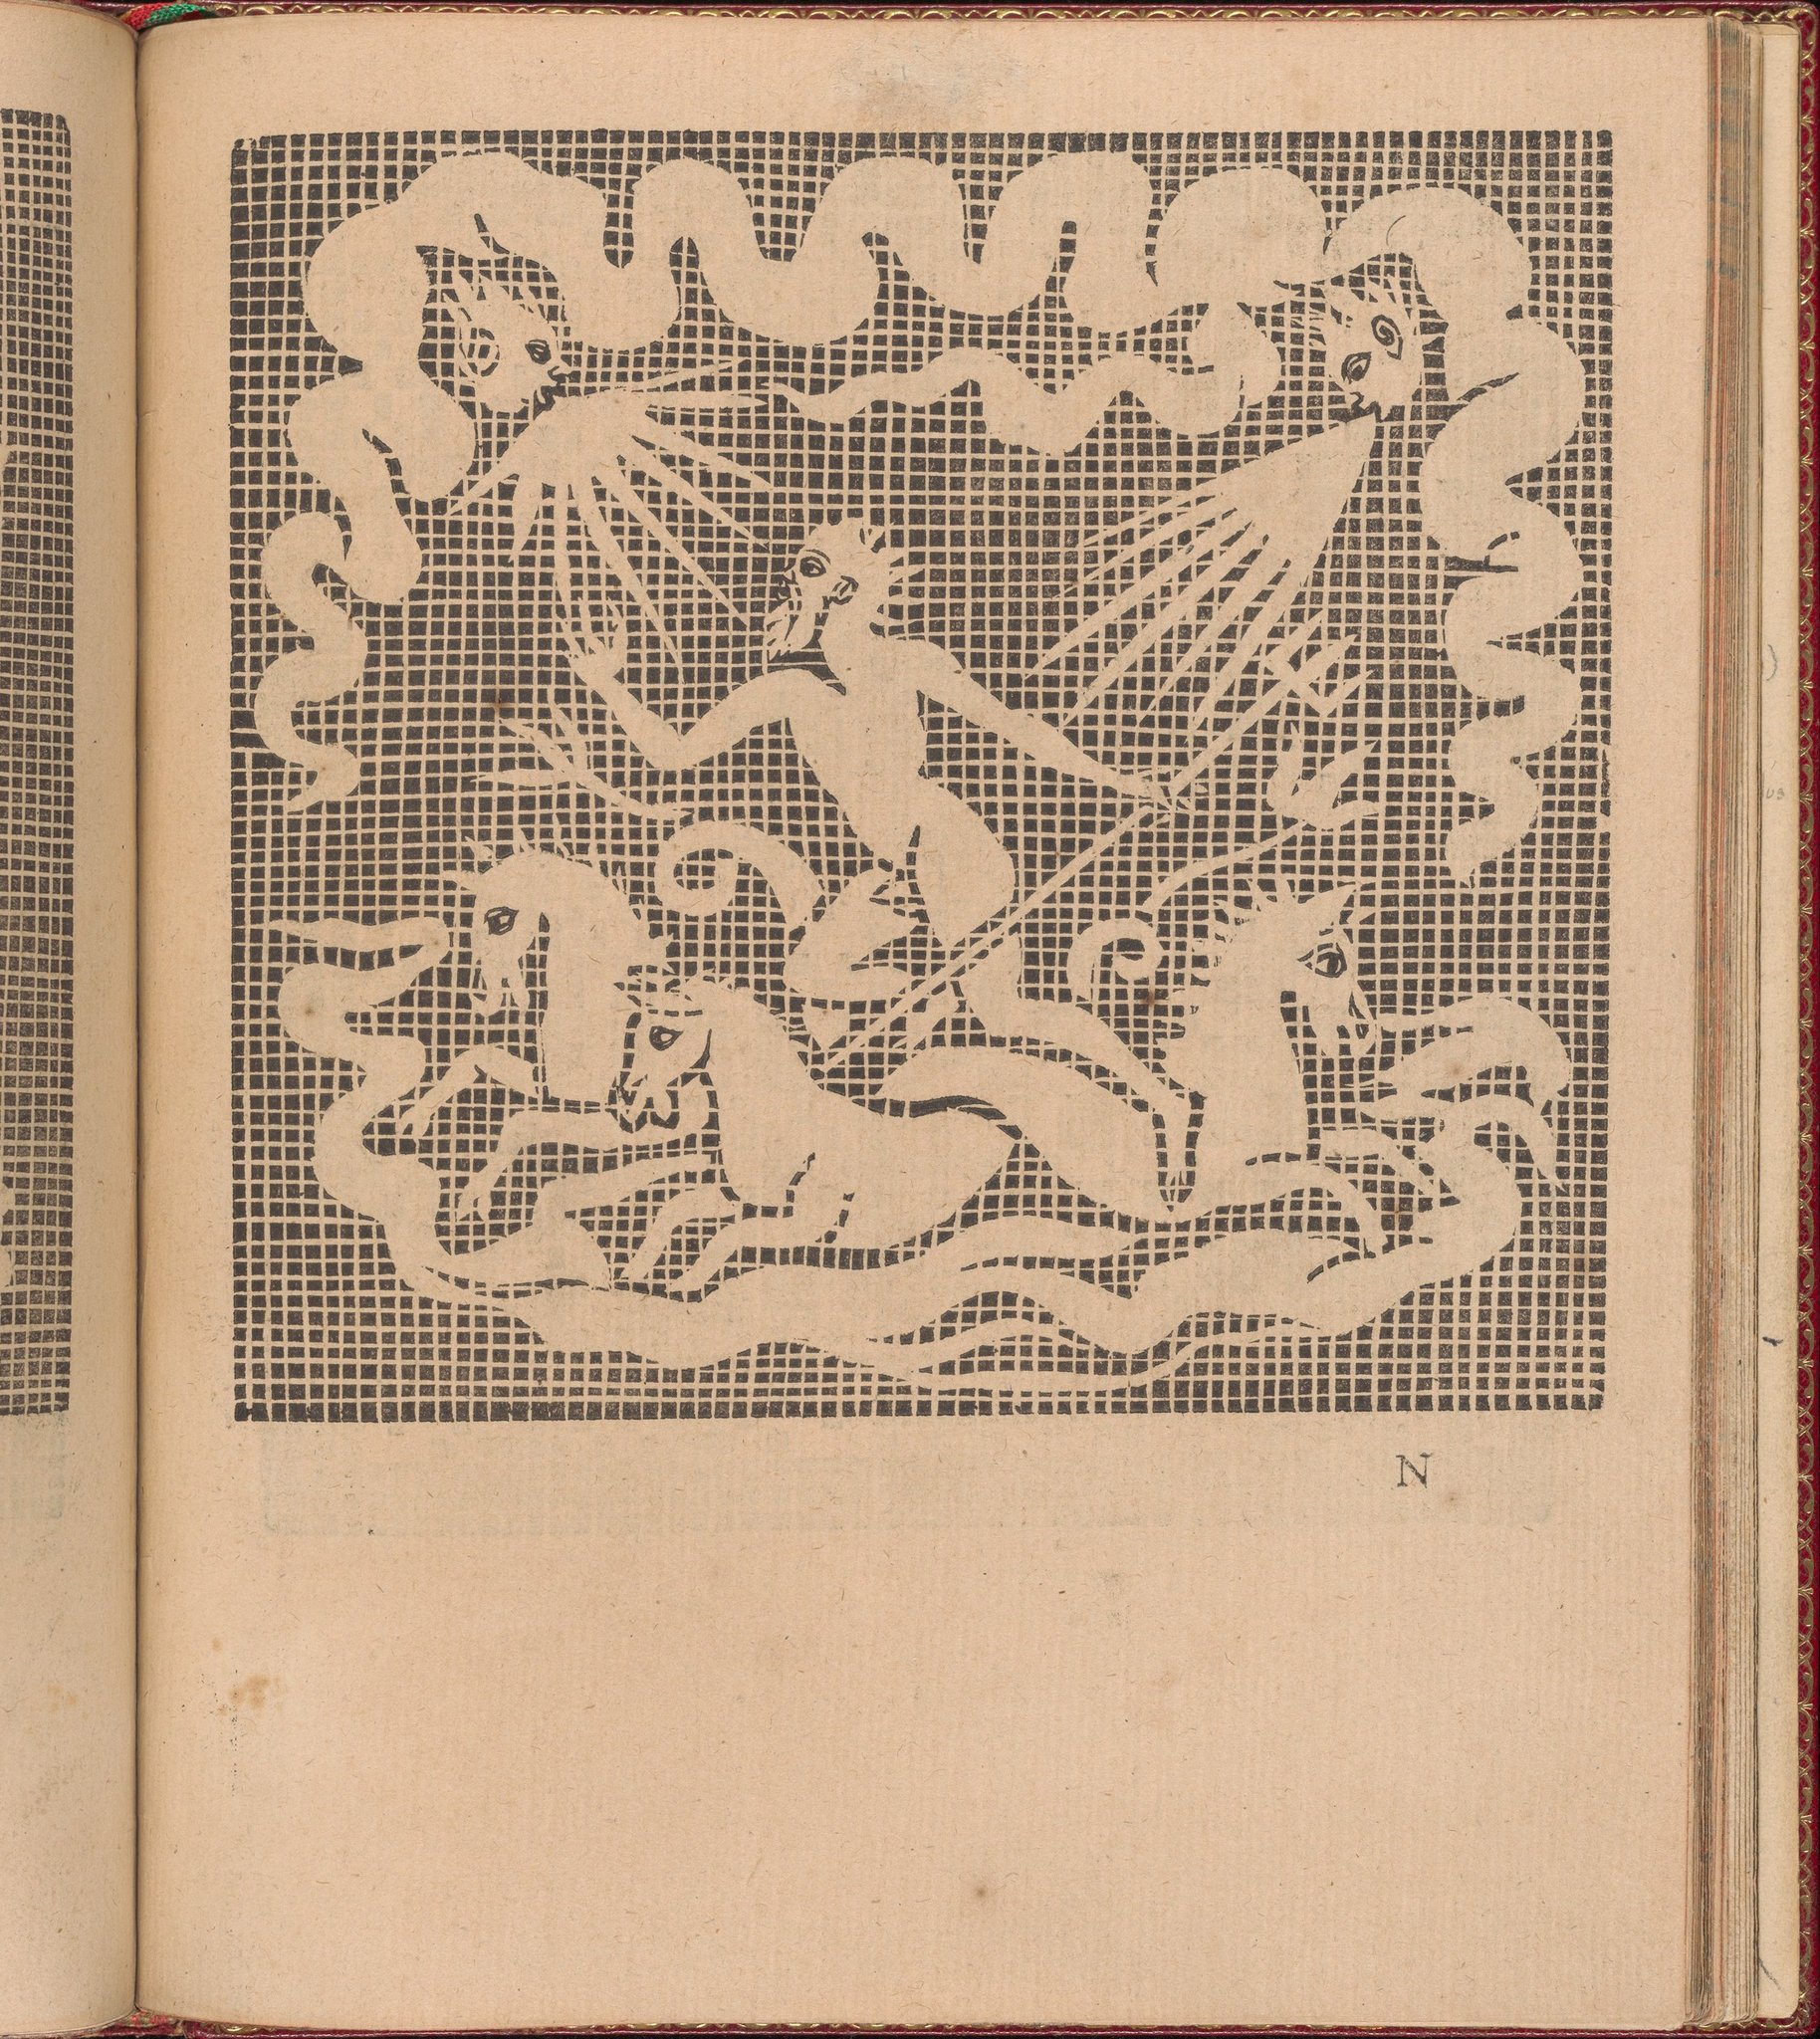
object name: book print ornament architecture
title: Les Singuliers et Nouveaux Portraicts... page 49 (recto)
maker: federico de vinciolo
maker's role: designer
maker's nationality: italian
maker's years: 1582-1599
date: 1588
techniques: woodcut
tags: poseidon,horses,waves